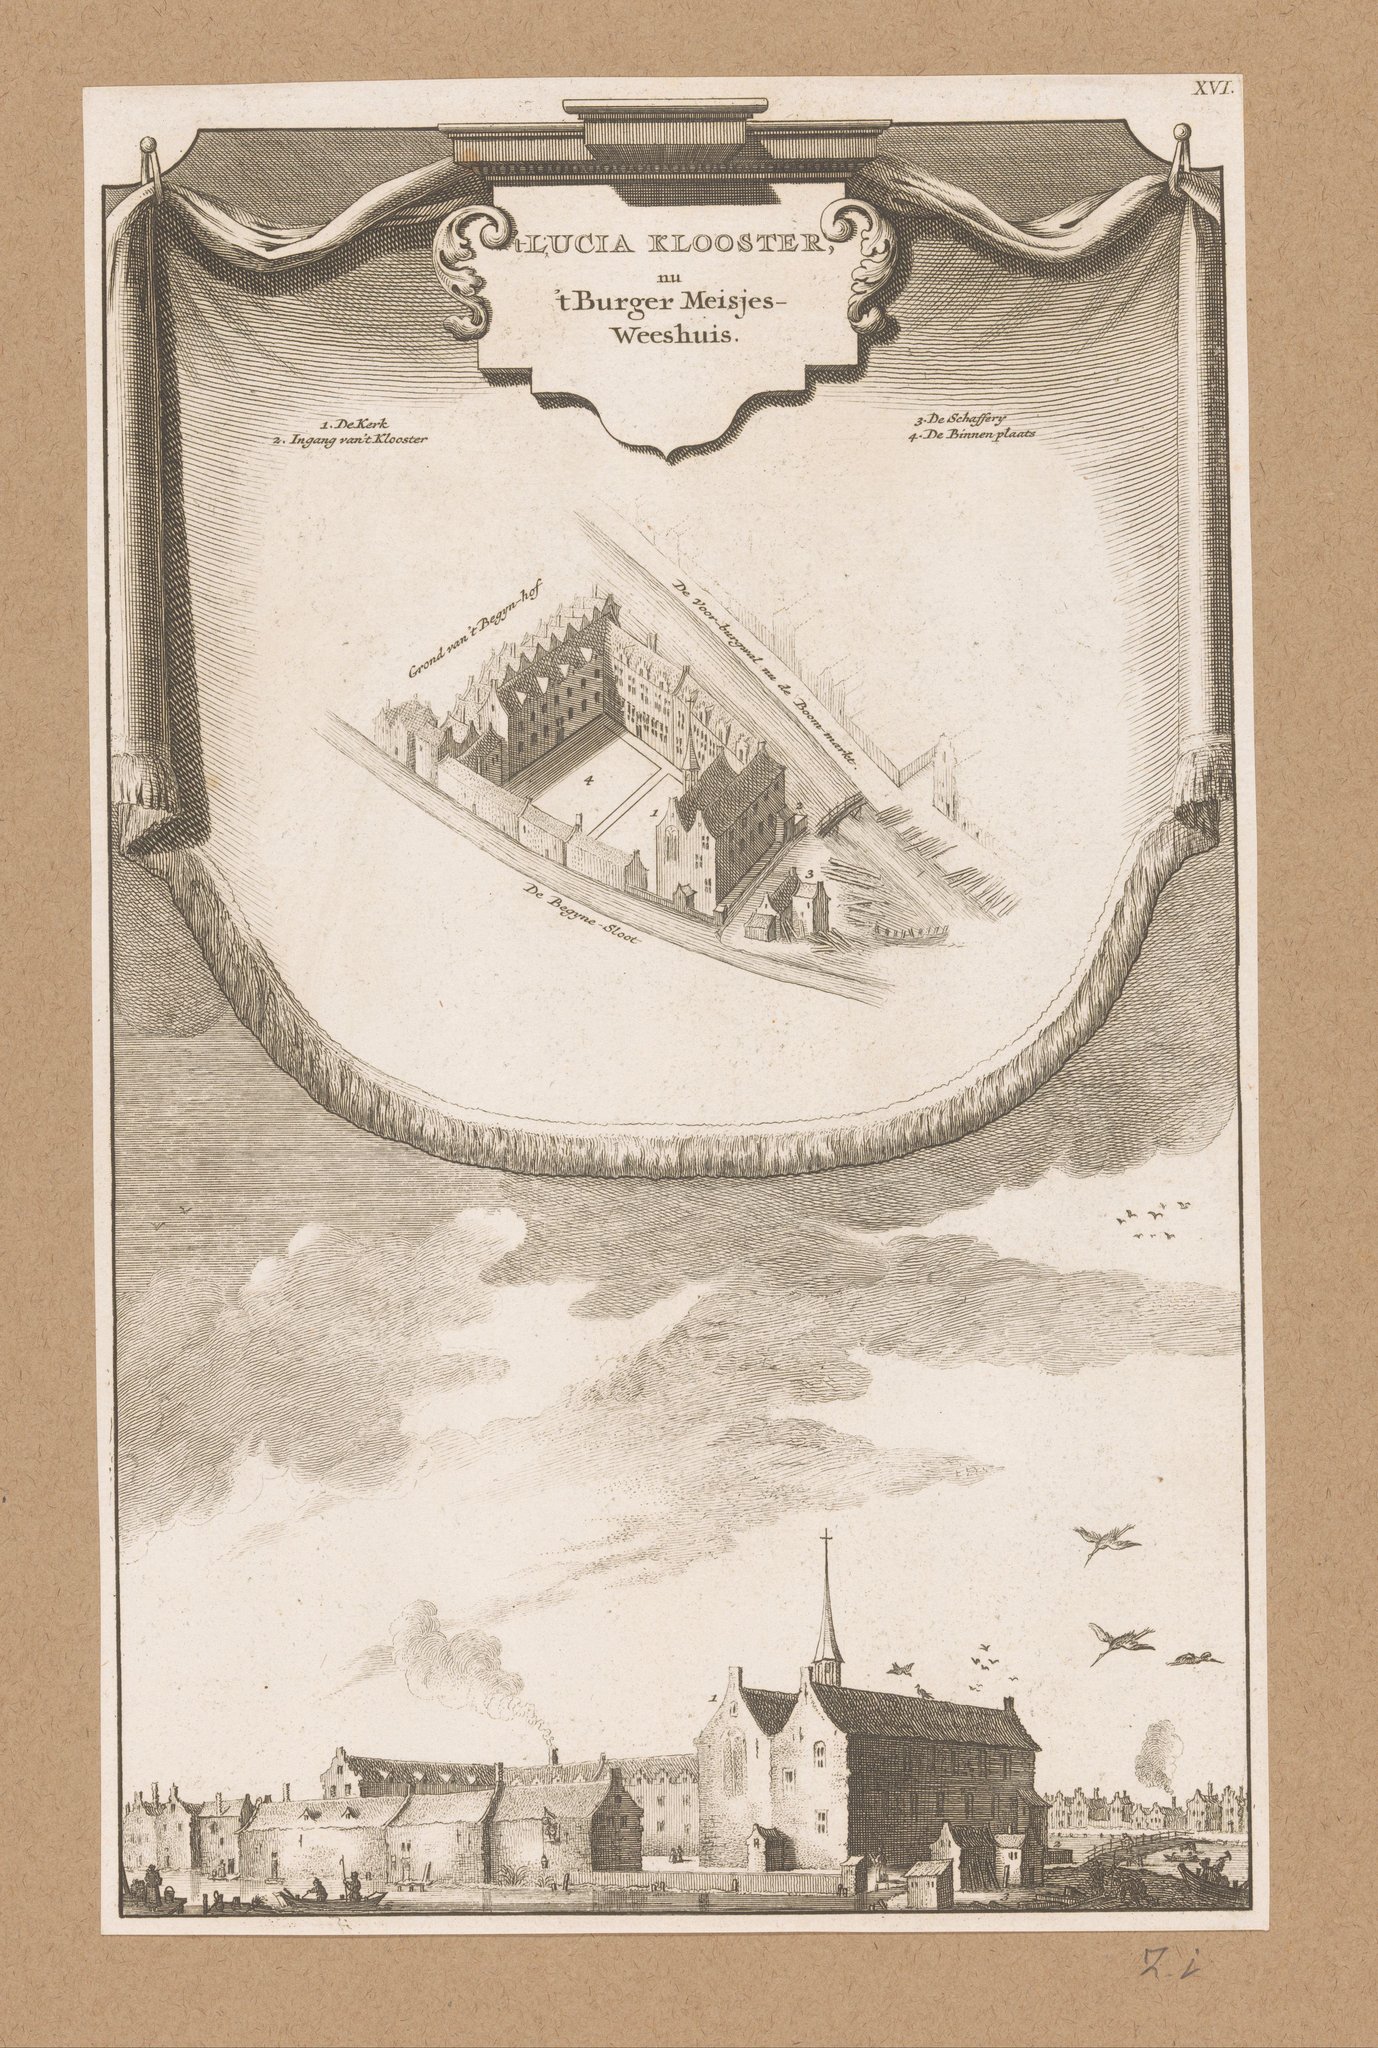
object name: book illustration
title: Gezichten op het Sint-Luciënklooster te Amsterdam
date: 1760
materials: paper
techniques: engraving, etching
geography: amsterdam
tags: abbey, monastery, convent ~ roman catholic church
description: Prent ook gebruikt in: Wagenaar, Jan. Amsterdam, in zyne opkomst, aanwas, geschiedenissen (…). 3 dln. [folio-uitgave]. Amsterdam: Isaak Tirion en Yntema & Tieboel, 1760-1767, dl. 1 (Isaac Tirion, 1760). Zie RP-P-AO-24X-33 voor proefdruk. Dat de prent de situatie rond 1544 weergeeft gaat terug op het feit dat voor het maken van deze en andere prenten van kloosters en kerken van voor de Alteratie (1578) is uitgegaan van de plattegrond van Cornelis Anthonisz. uit 1544 (zie RP-P-OB-70.399 en RP-P-AO-20-15).